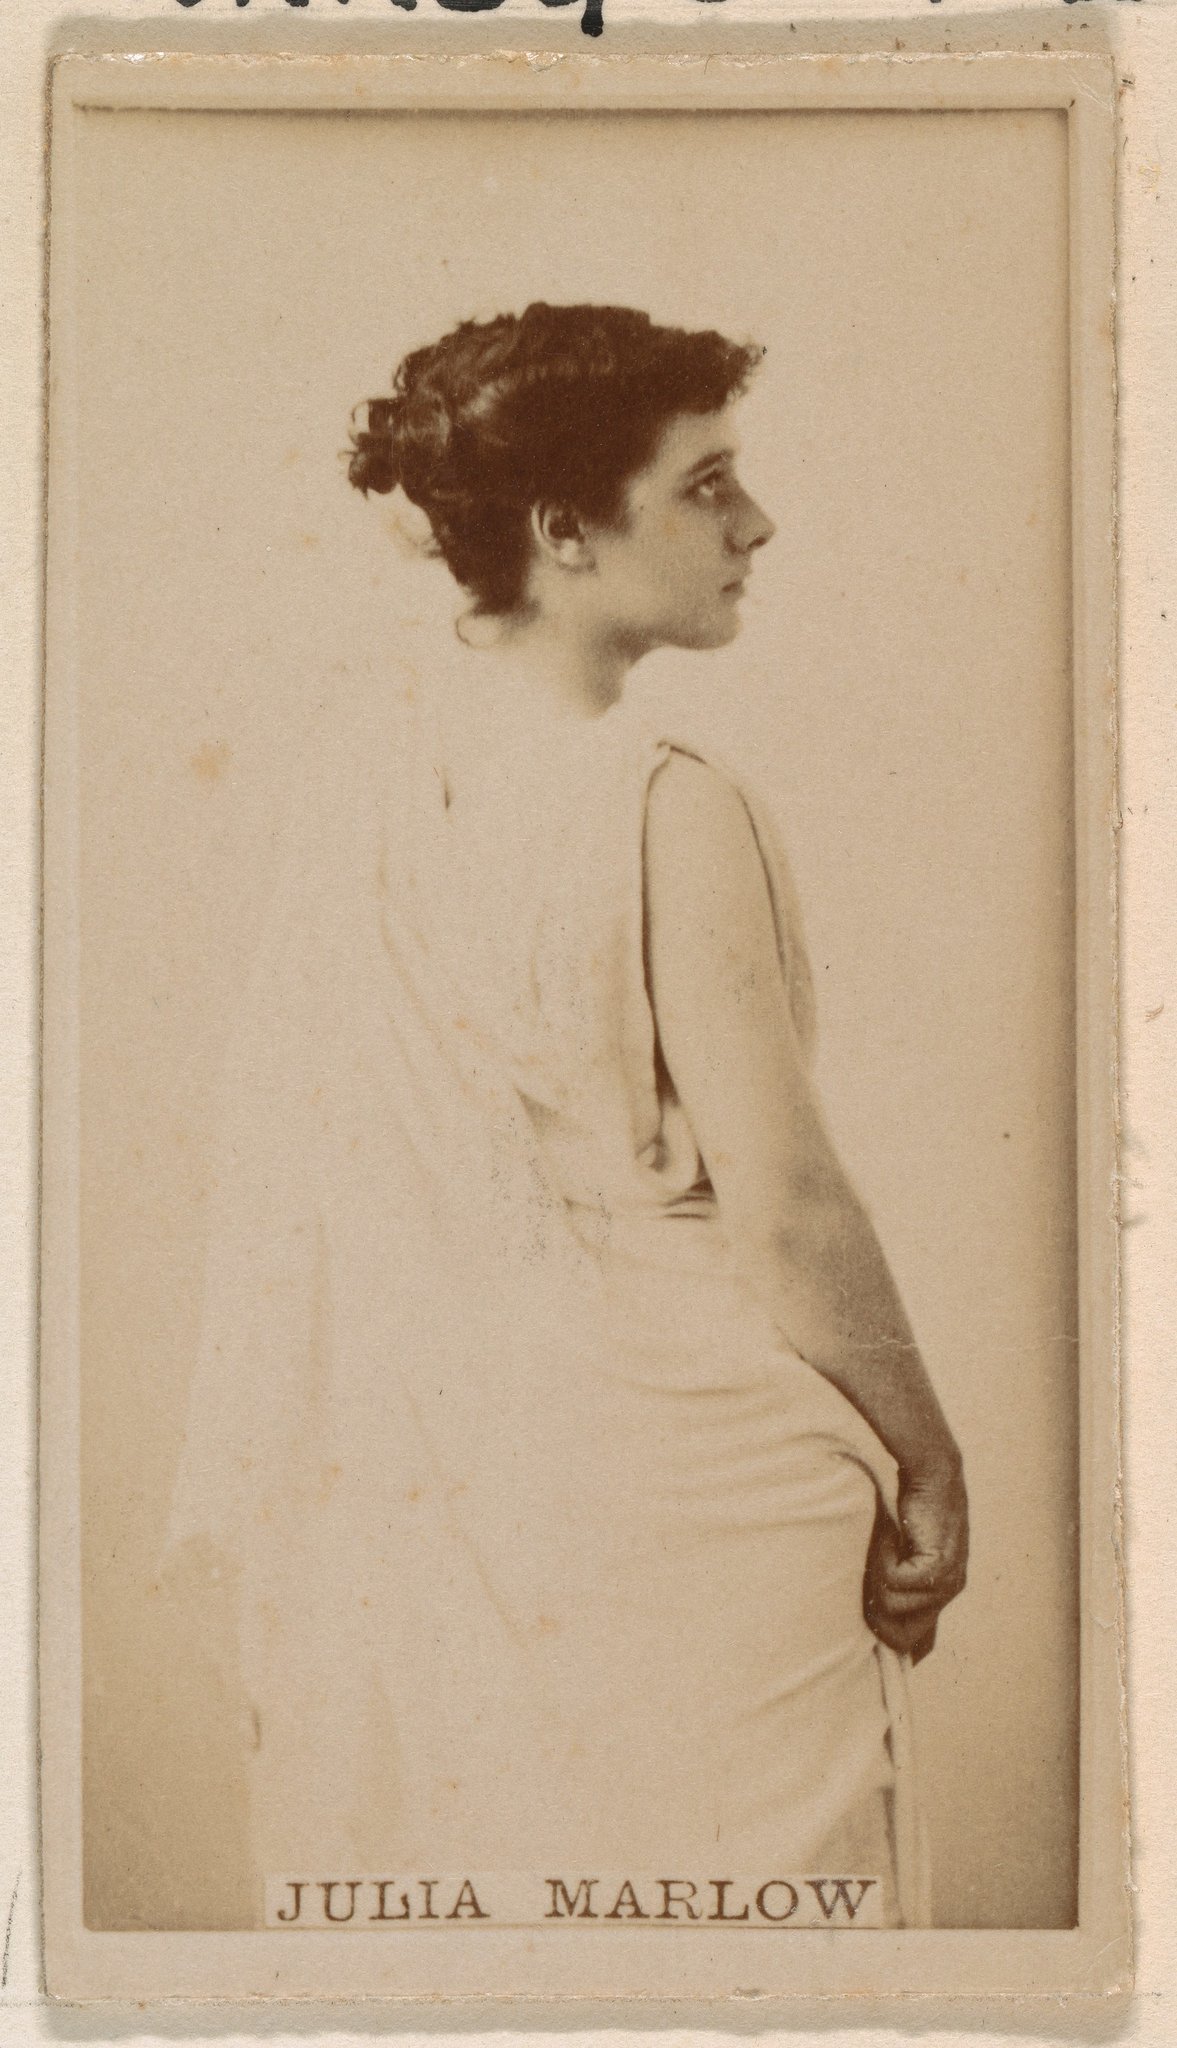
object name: photograph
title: Julia Marlow, from the Actresses series (N245) issued by Kinney Brothers to promote Sweet Caporal Cigarettes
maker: kinney brothers tobacco company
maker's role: publisher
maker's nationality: american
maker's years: 1869-2011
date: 1890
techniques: albumen silver print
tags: women,actresses